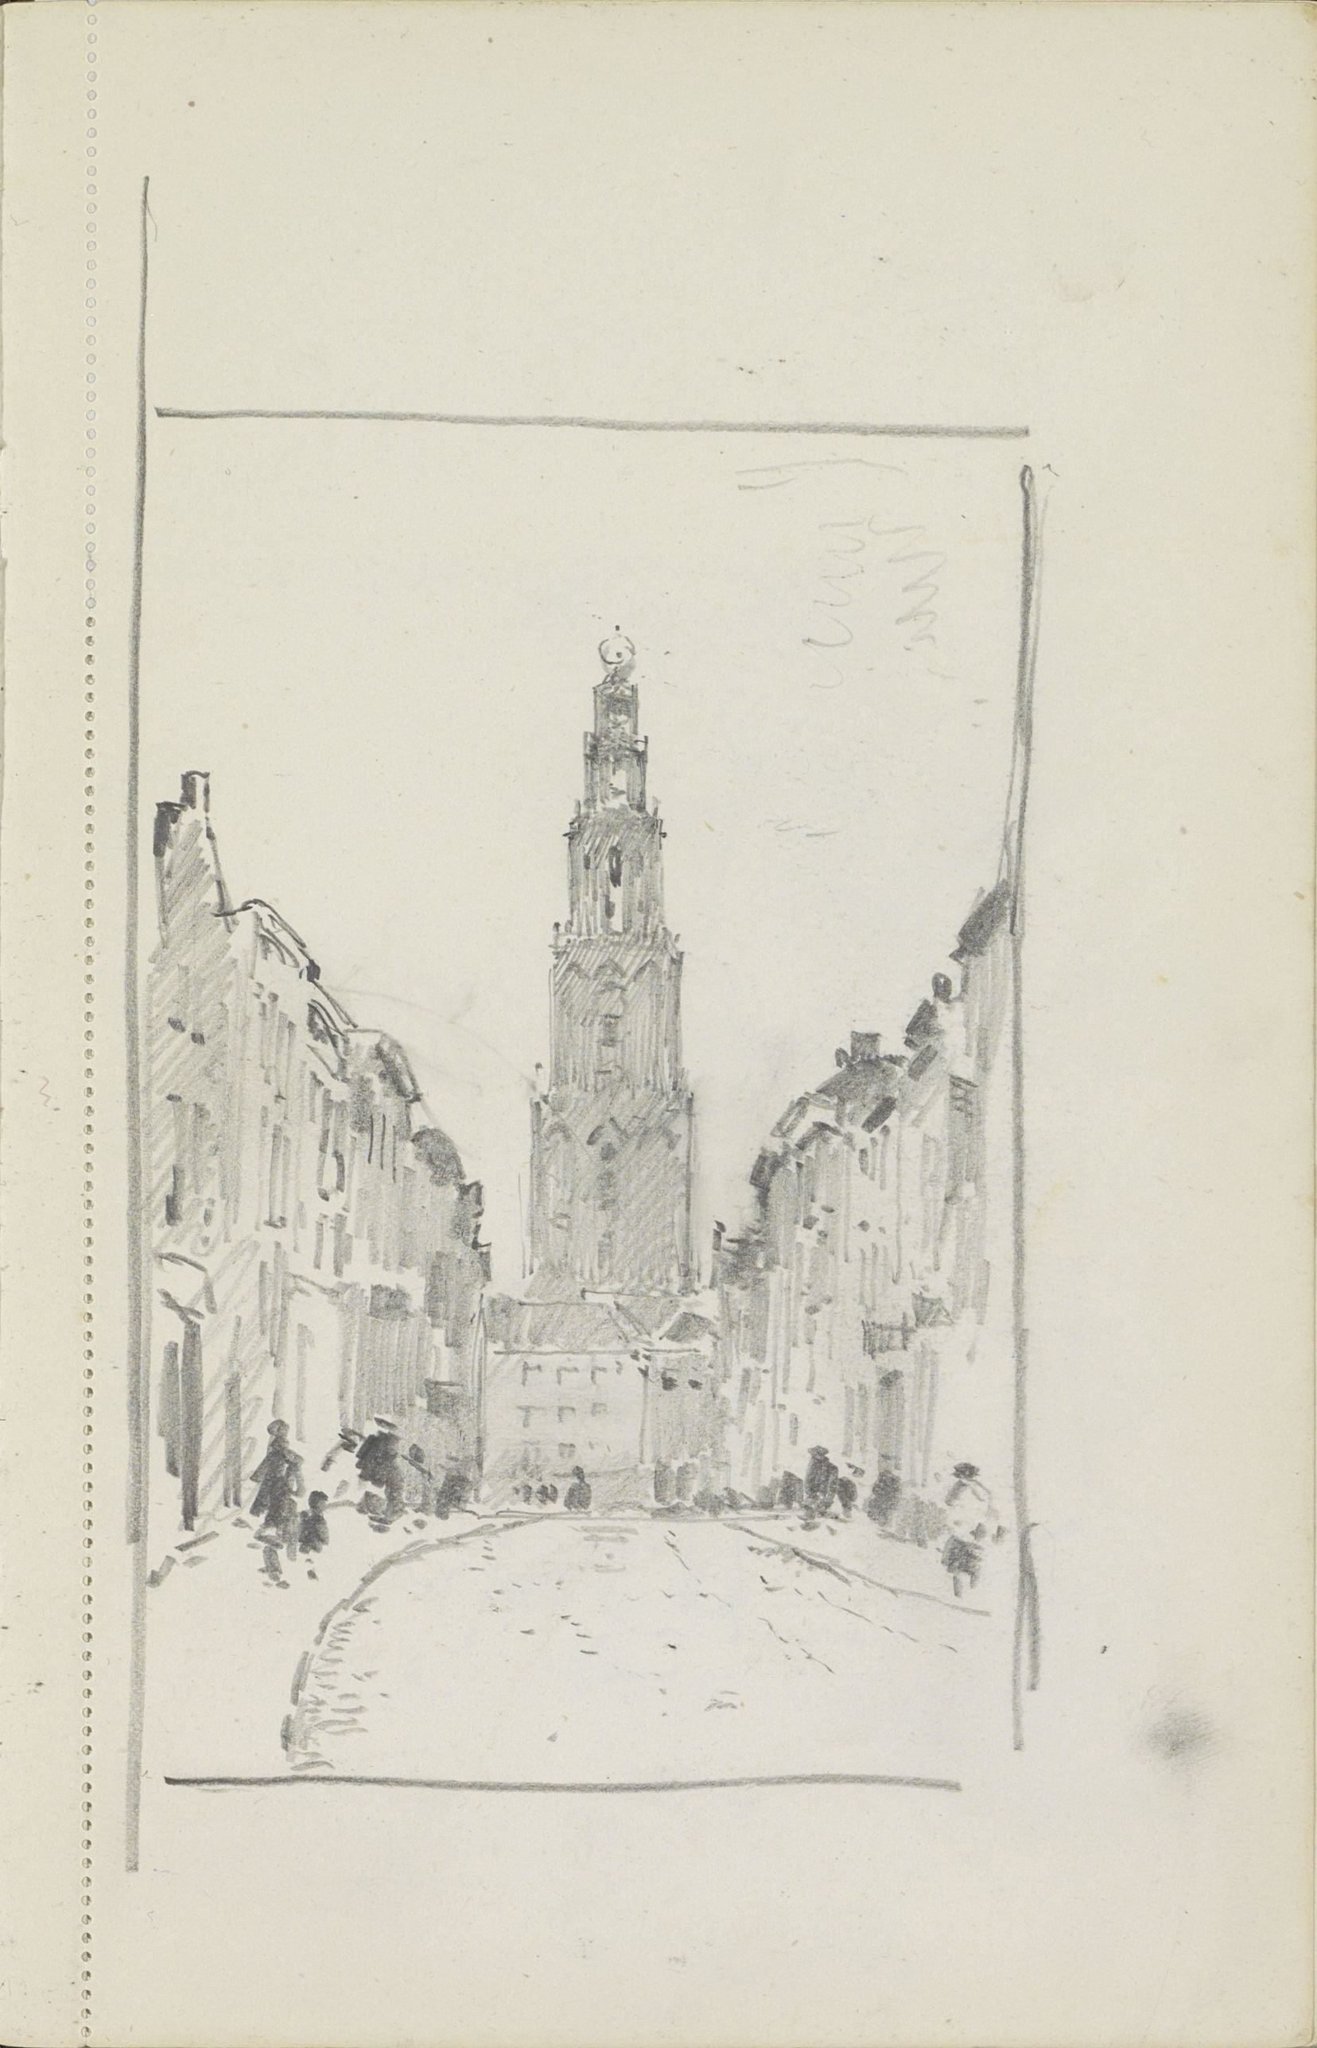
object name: sketchbook leaf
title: Gezicht op de Martinikerk te Groningen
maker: cornelis vreedenburgh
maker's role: draughtsman, print maker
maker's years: 1880-1946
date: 1890-1946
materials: paper, pencil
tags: street (+ city(-scape) with figures, staffage), parts of church exterior and annexes: tower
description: Blad 4 recto uit een schetsboek met 50 bladen.